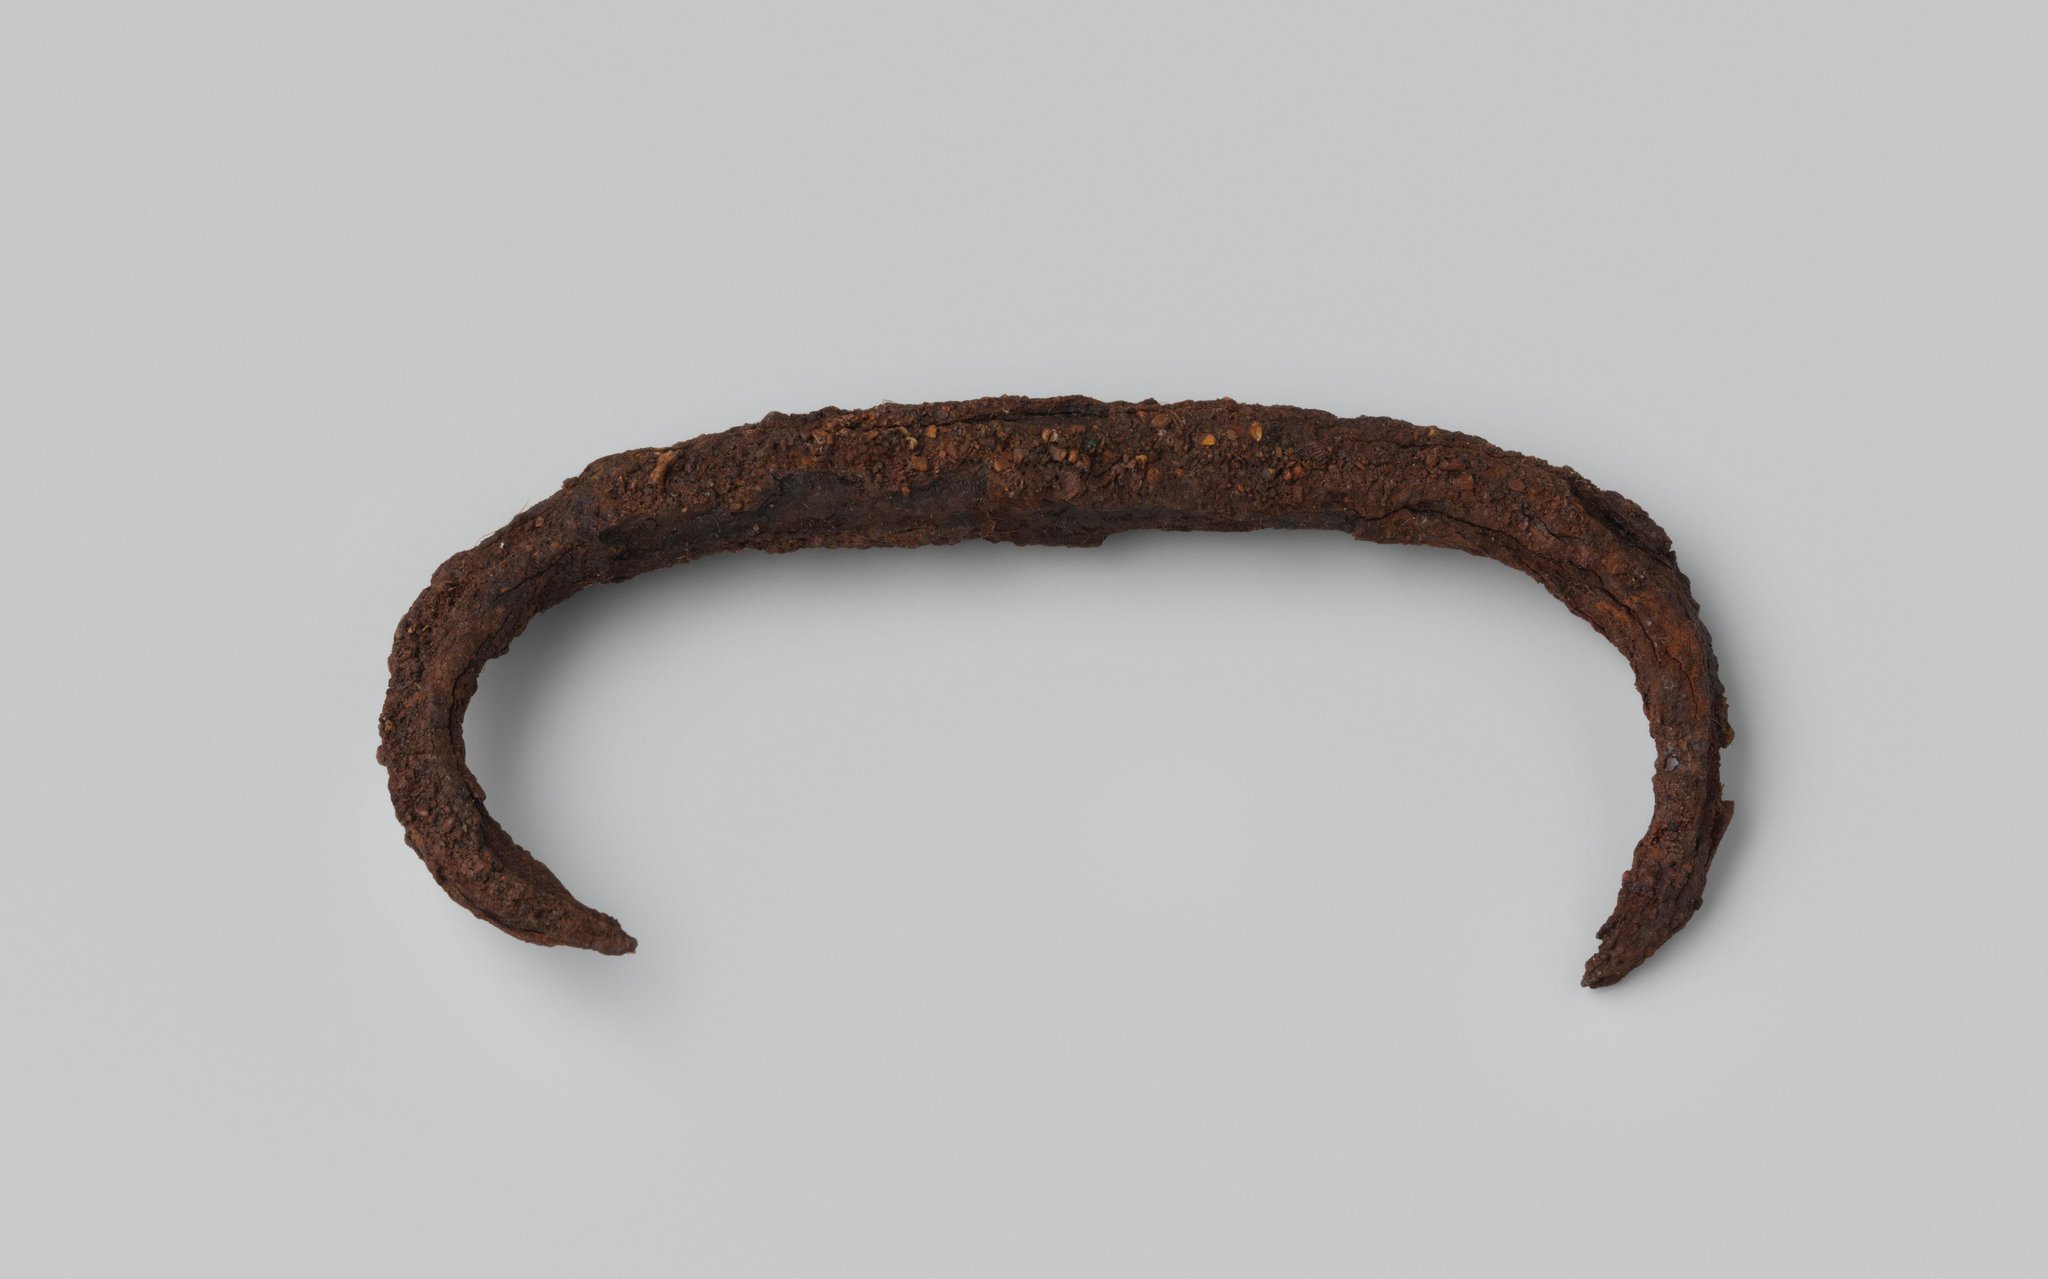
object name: bail handle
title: Beugelhandvat uit het wrak van de Oost-Indiëvaarder Hollandia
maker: Anonymous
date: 1700-1743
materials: iron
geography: netherlands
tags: verenigde oostindische compagnie, hollandia (schip), annet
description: Fittings, handles, bail handle; fragm, eroded: oval, circular in section, incurved tapering ends.